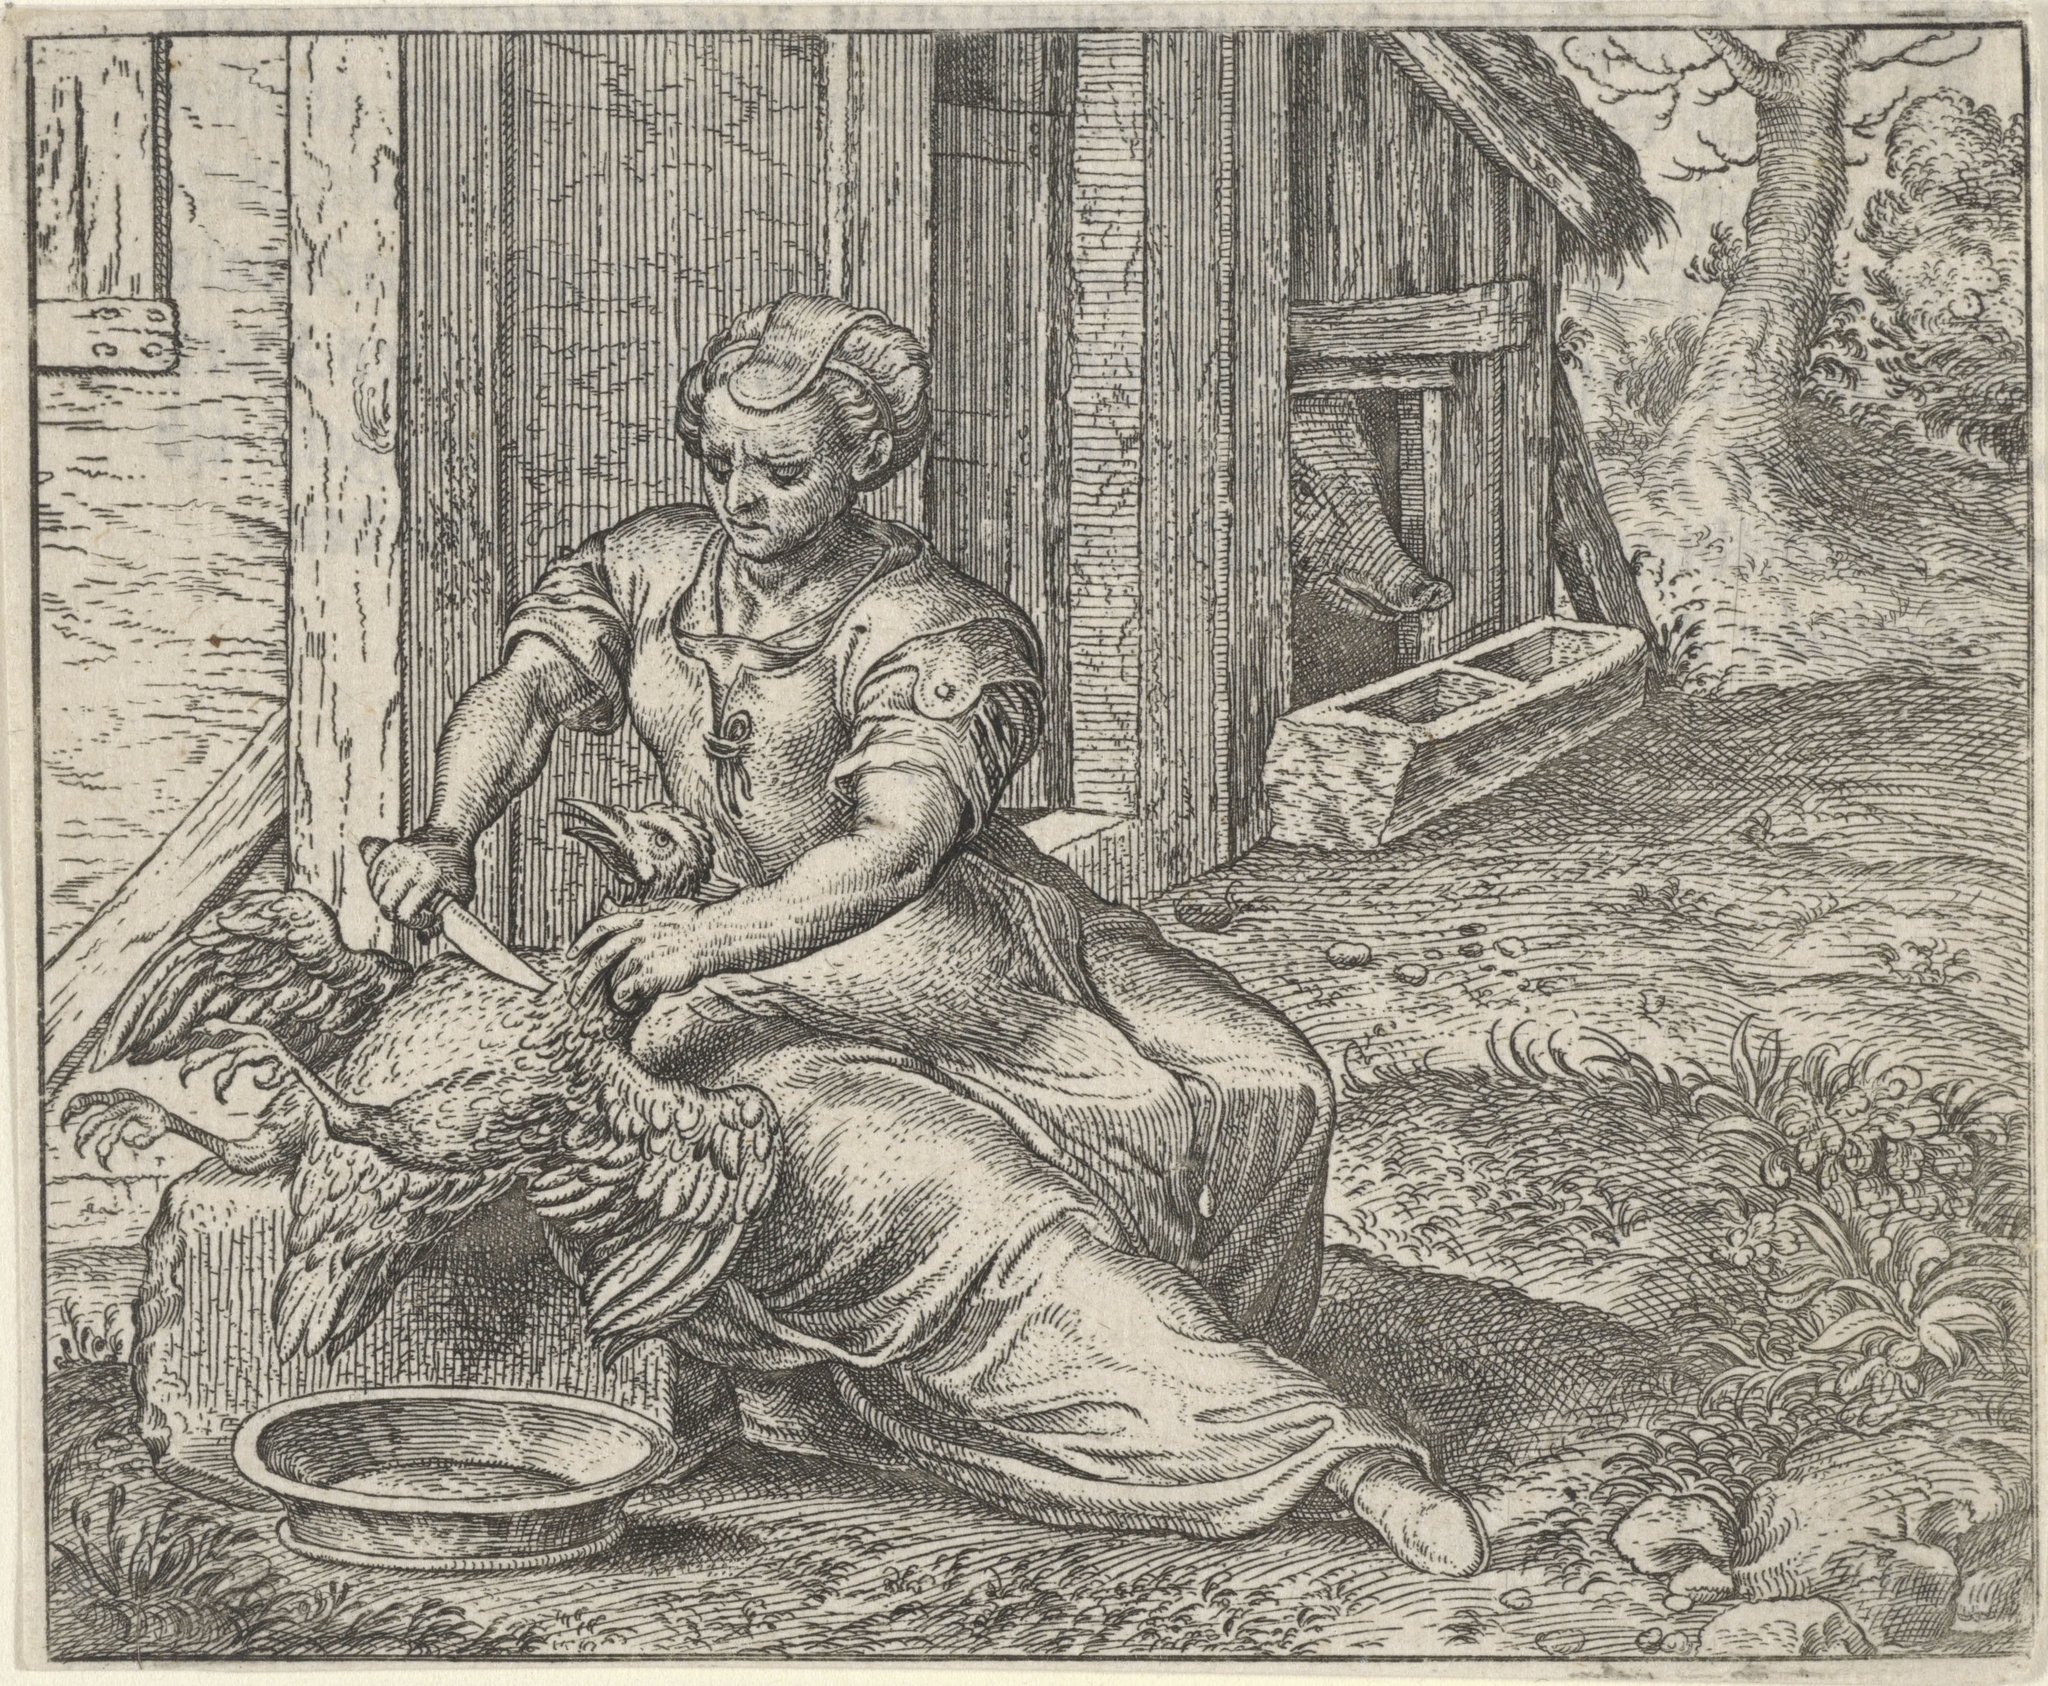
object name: print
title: Fabel van de vrouw en de kip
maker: aegidius sadeler (ii)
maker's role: draughtsman, print maker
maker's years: 1568-1629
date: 1608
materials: paper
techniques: engraving, etching, letterpress printing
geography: prague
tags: fables, fowl (cock, hen, chicken, etc.) (+ animal killed by man)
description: Een vrouw houdt een mes tegen de keel van een kip en staat klaar om het beest te slachten. Op de achtergrond een boerderij. De fabel beschrijft hoe een kip elke dag een gouden ei legt. Haar eigenares is hebzuchtig en slacht de kip in de hoop de bron van het goud te ontdekken. De moraal van het verhaal leert dat men genoegen moet nemen met wat men heeft.